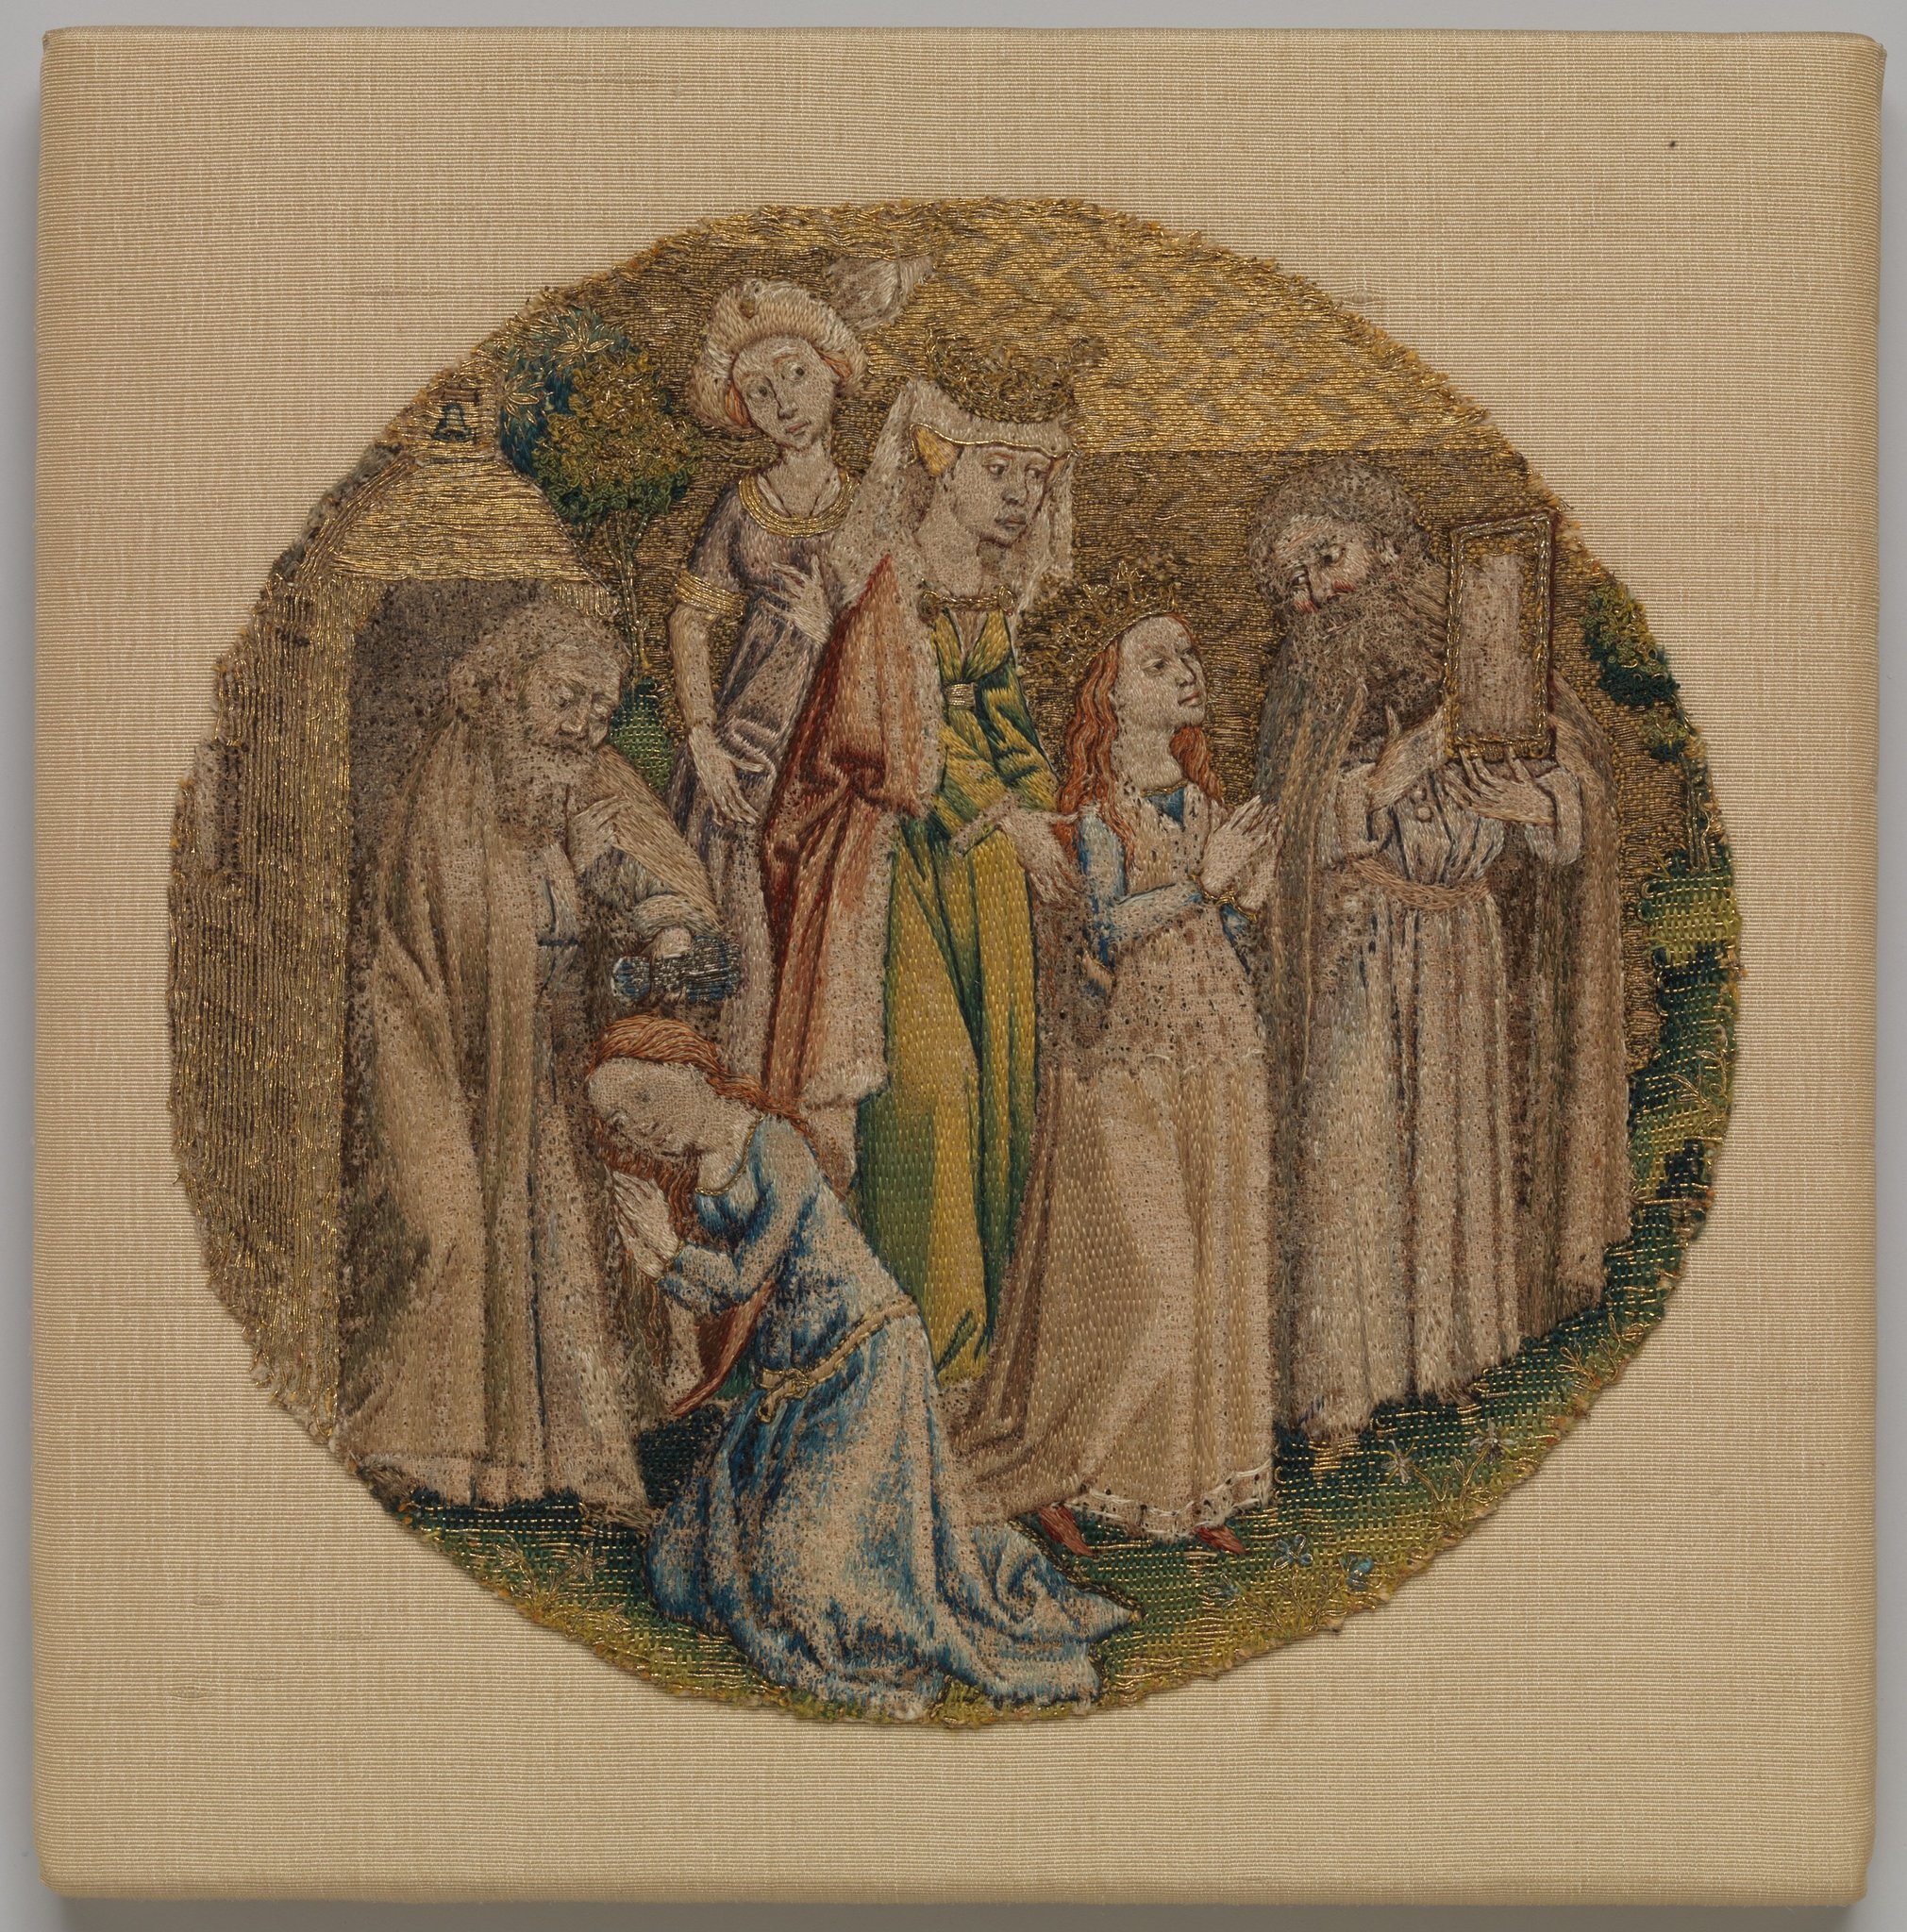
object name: roundel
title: The Hermit Adrian Shows St. Catherine an Image of Christ and Baptizes Her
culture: south netherlandish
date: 1430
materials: linen, metal thread, silk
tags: men,women,saint catherine